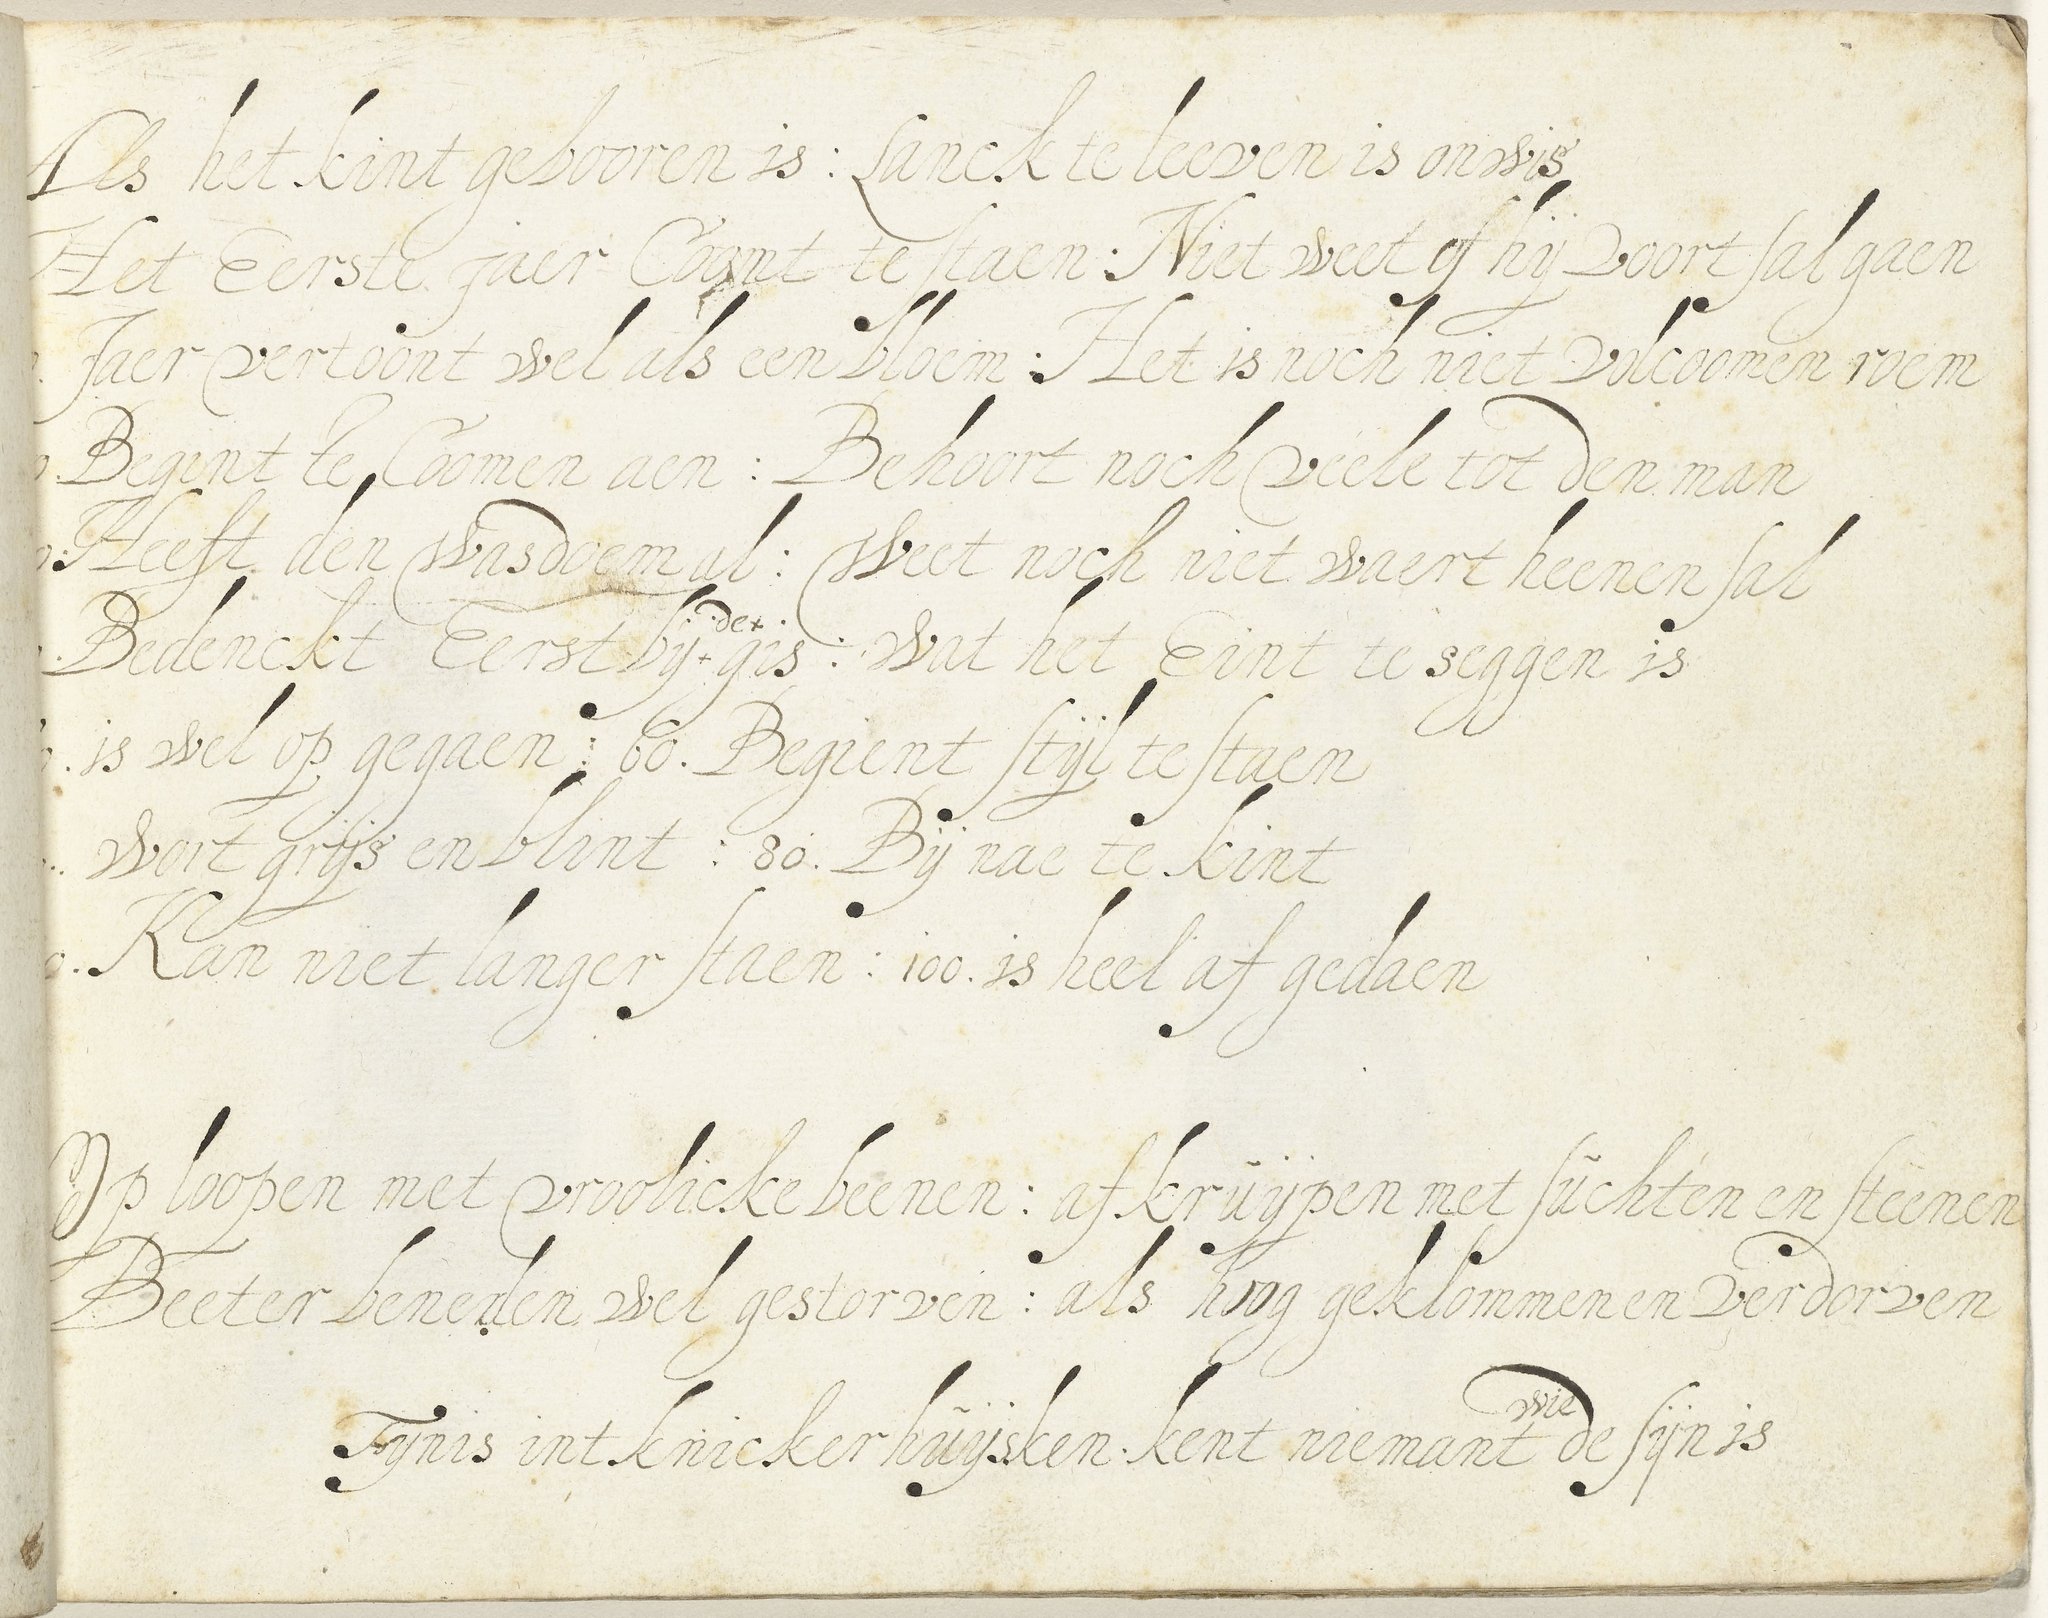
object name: calligraphy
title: Gedicht met daaronder twee aforismen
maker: gesina ter borch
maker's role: draughtsman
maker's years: 1633-1690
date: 1646-1650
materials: ink, paper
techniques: calligraphy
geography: zwolle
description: Gedicht De Trap van het leven; onderaan twee aforismen.